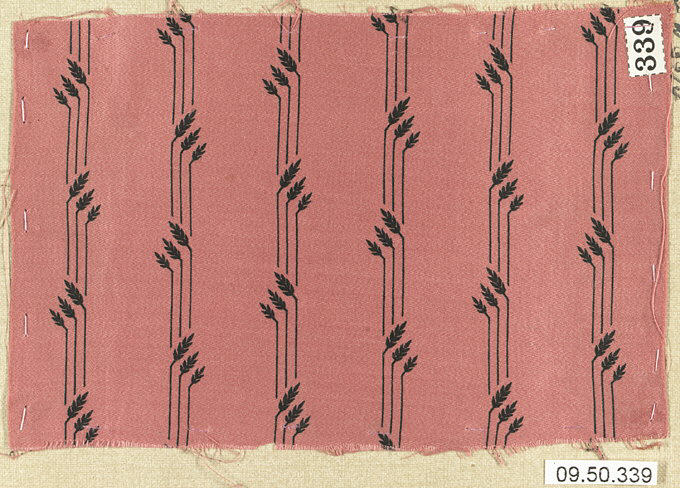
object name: piece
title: Piece (one of 116)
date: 1801-1900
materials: cotton